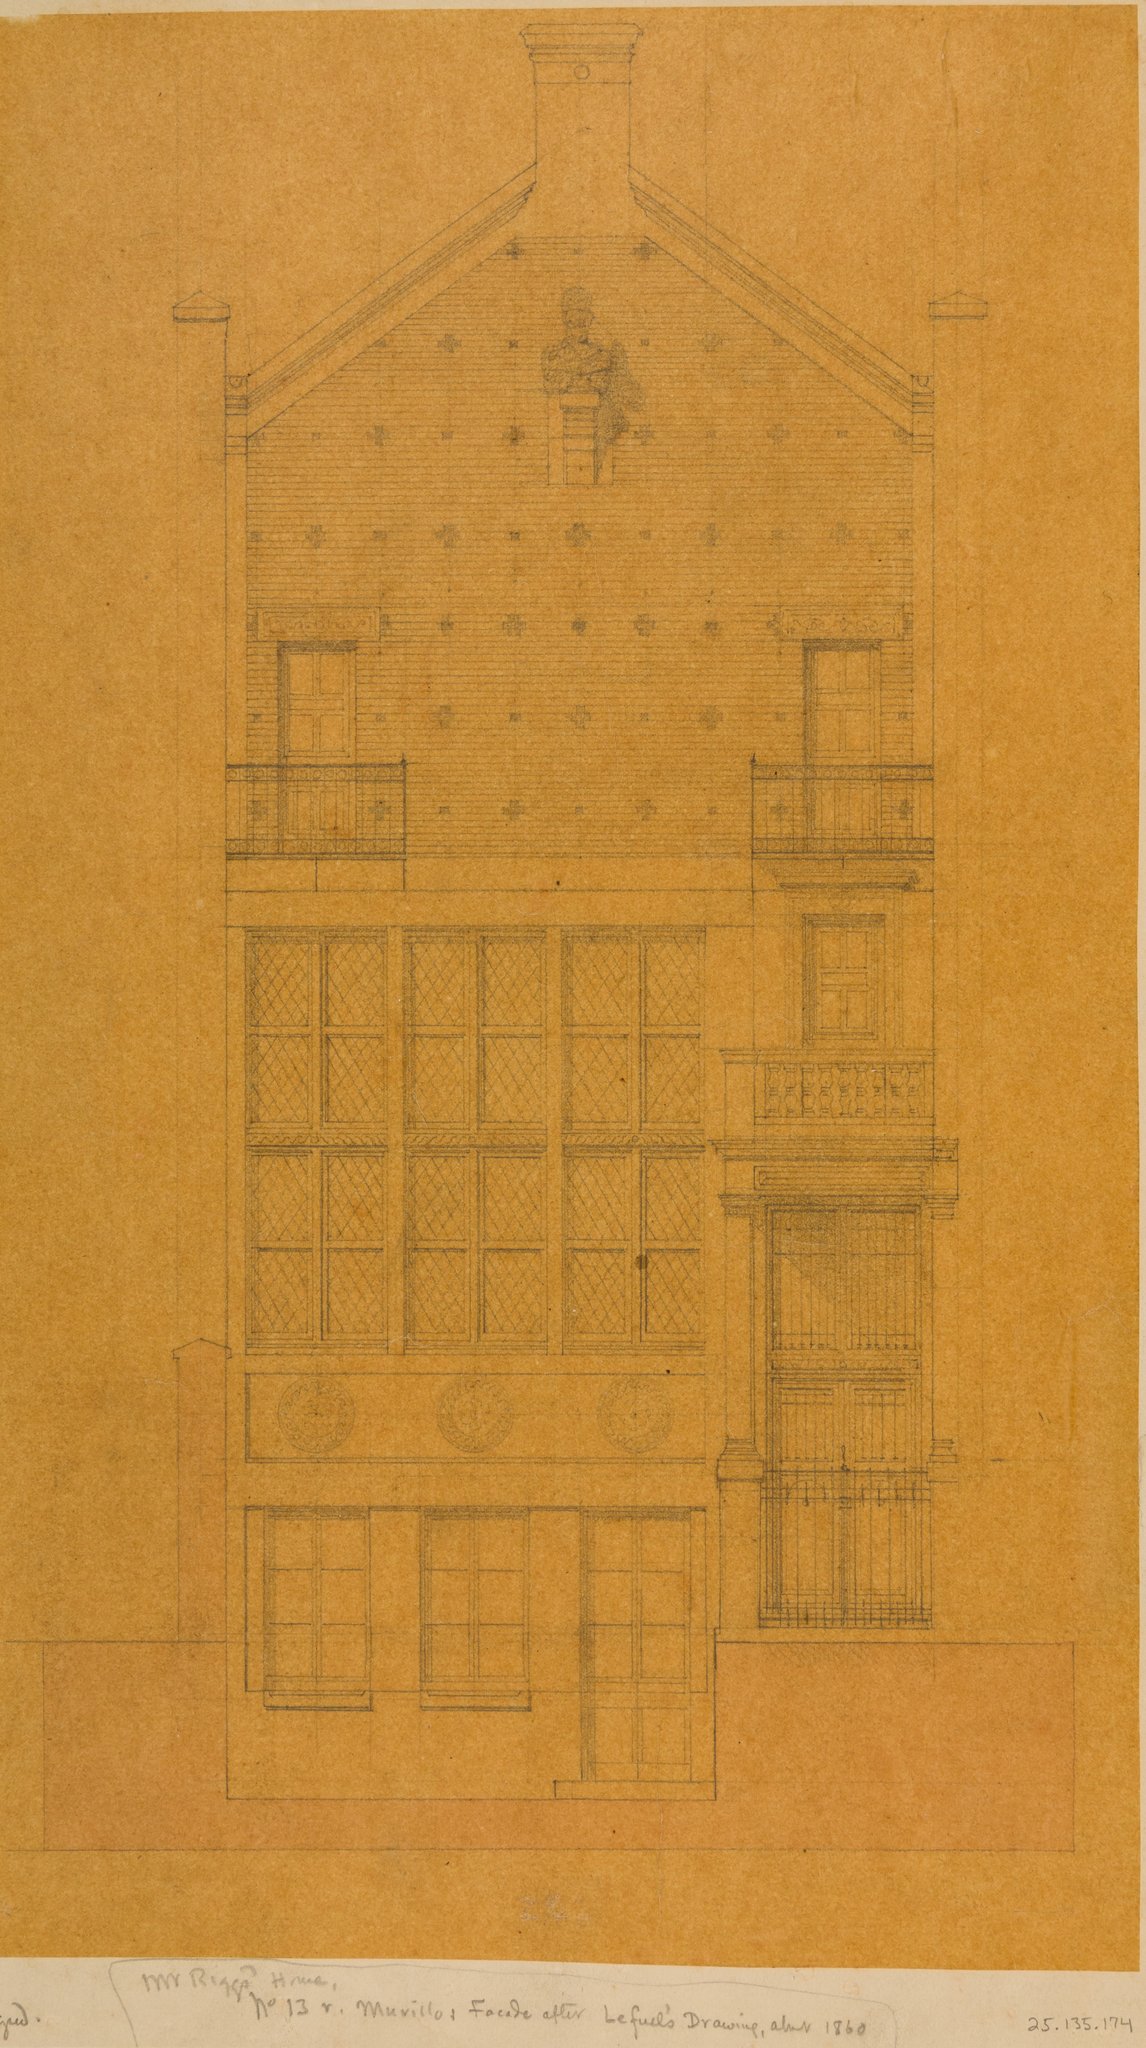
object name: drawing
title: Architectural Drawing of the Exterior of the Comte de Nieuwerkerke's House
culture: french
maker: hector-martin lefuel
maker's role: artist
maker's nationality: french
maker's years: 1810-1880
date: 1870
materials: paper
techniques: pen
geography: france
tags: architecture,houses